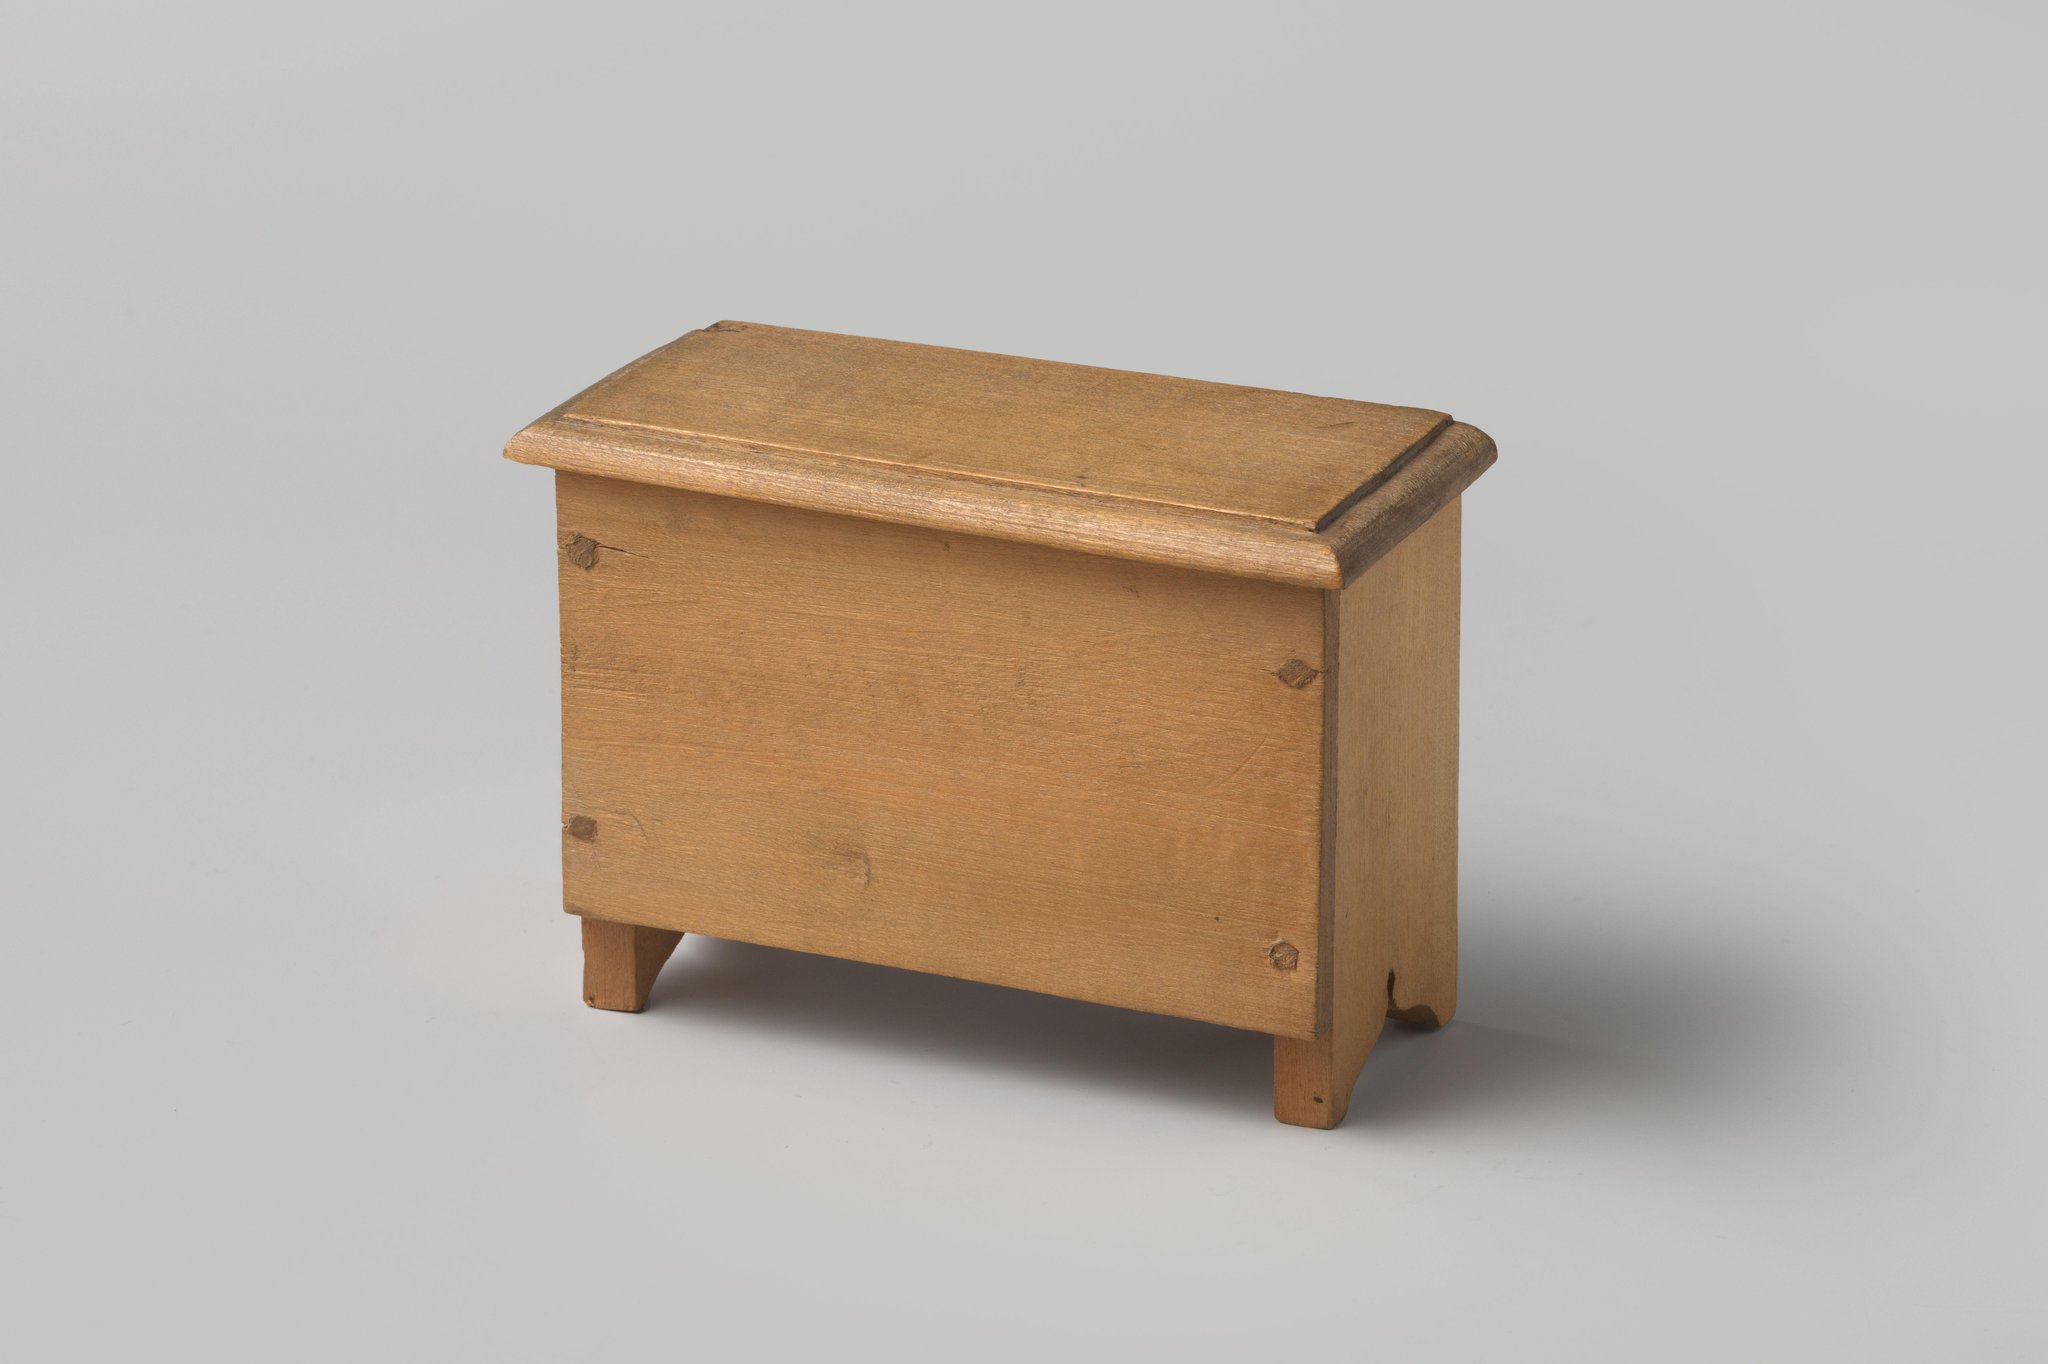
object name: miniature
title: Aanrecht van without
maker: Anonymous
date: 1676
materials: iron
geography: amsterdam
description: Aanrecht, rechthoekig, van without. Het aanrecht is geconstrueerd uit twee zijwanden met accoladevormige uitsnijdingen in de onderrand, een daarop gespijkerd voorblad en een bovenblad met een kwartrond profiel. Enige detaillering in de vorm van een deurtje of een kastruimte ontbreekt.